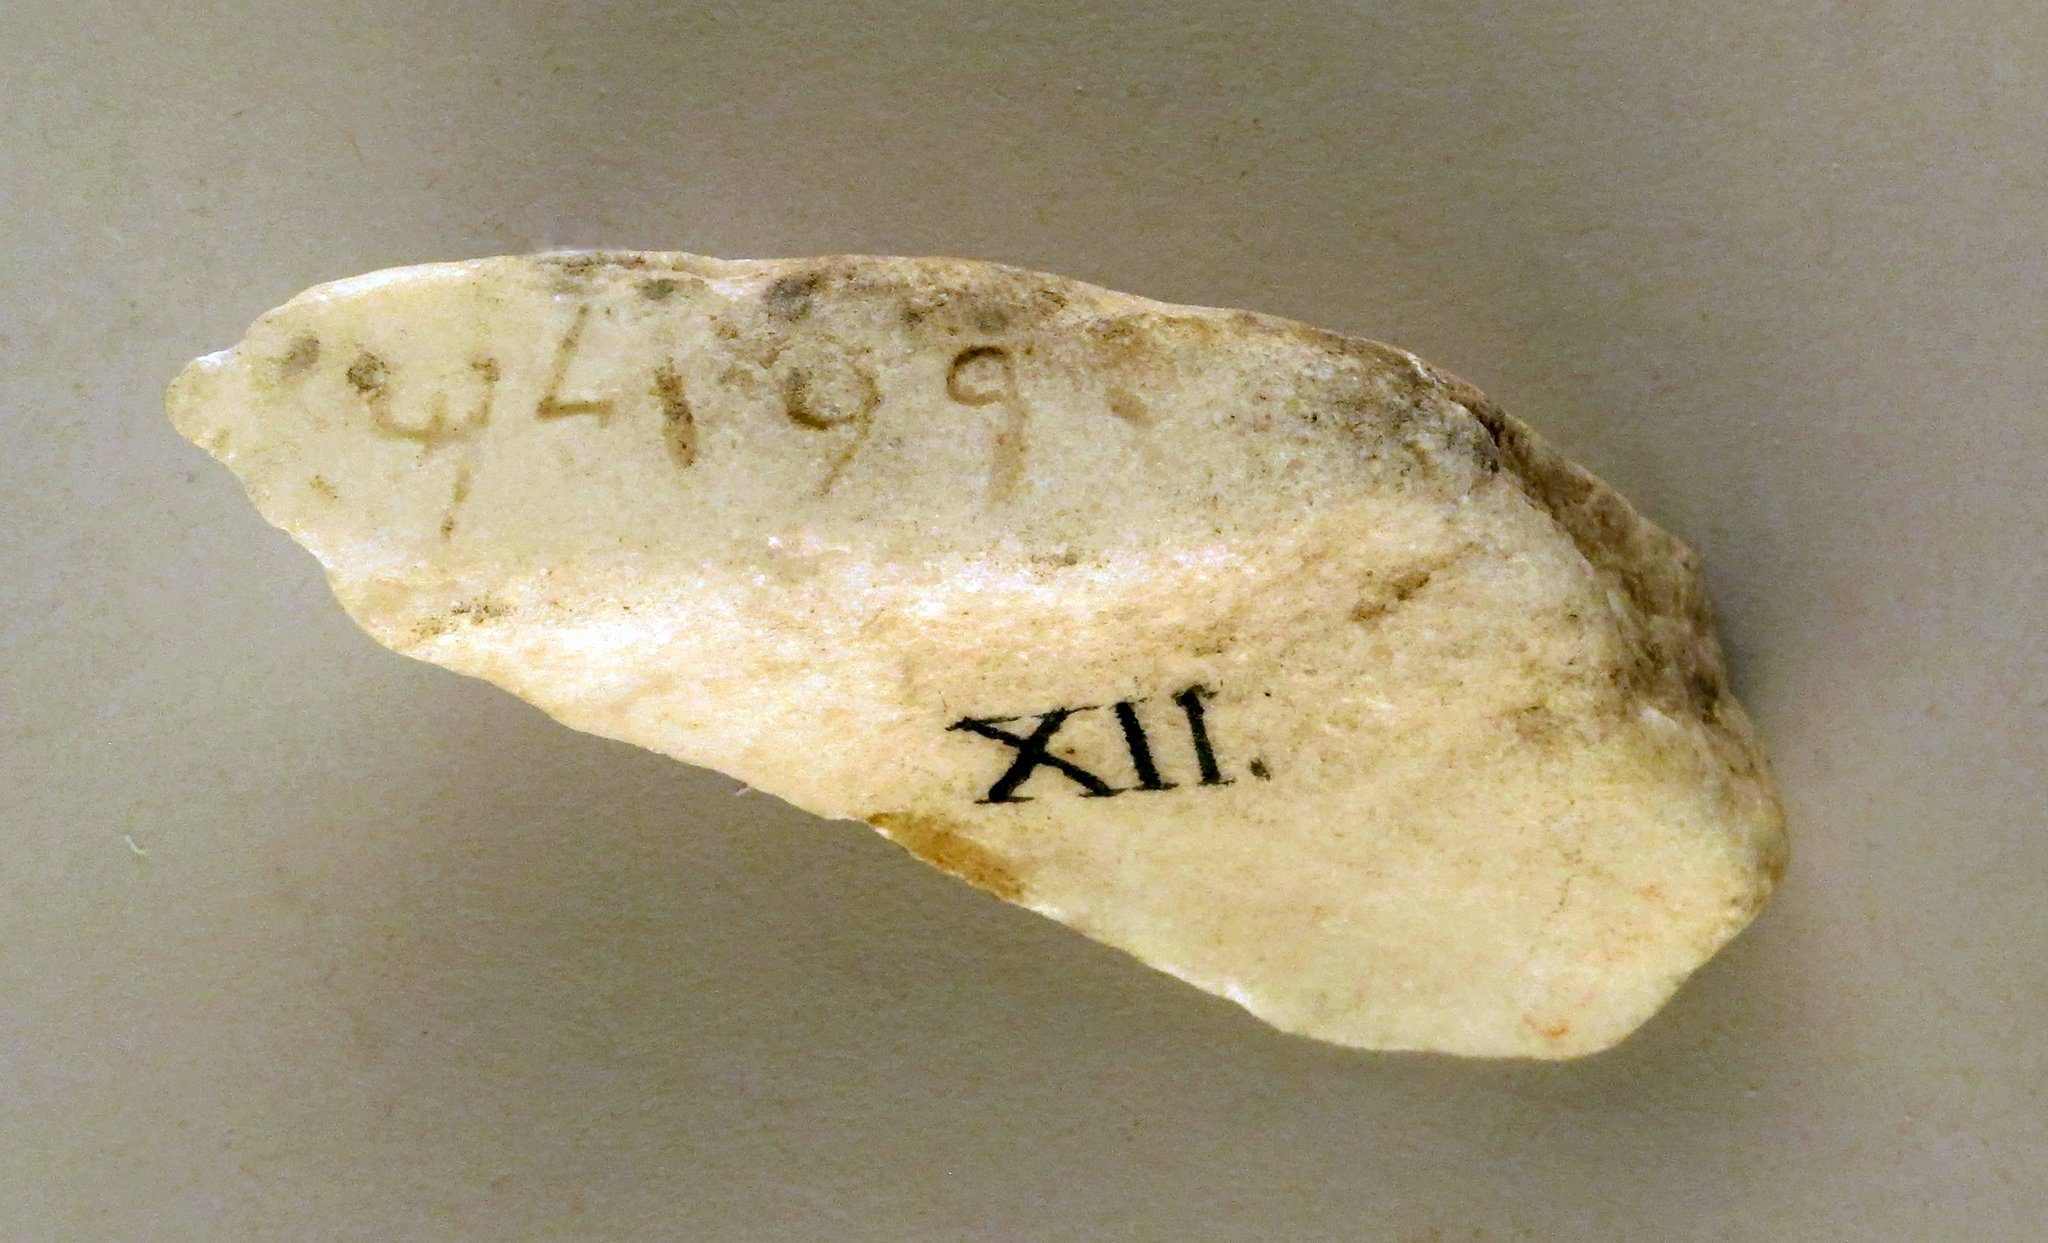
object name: bowl, fragmentary, phoenician inscription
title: Marble bowl fragment with Phoenician inscription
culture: cypriot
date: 389 BCE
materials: marble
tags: phoenician